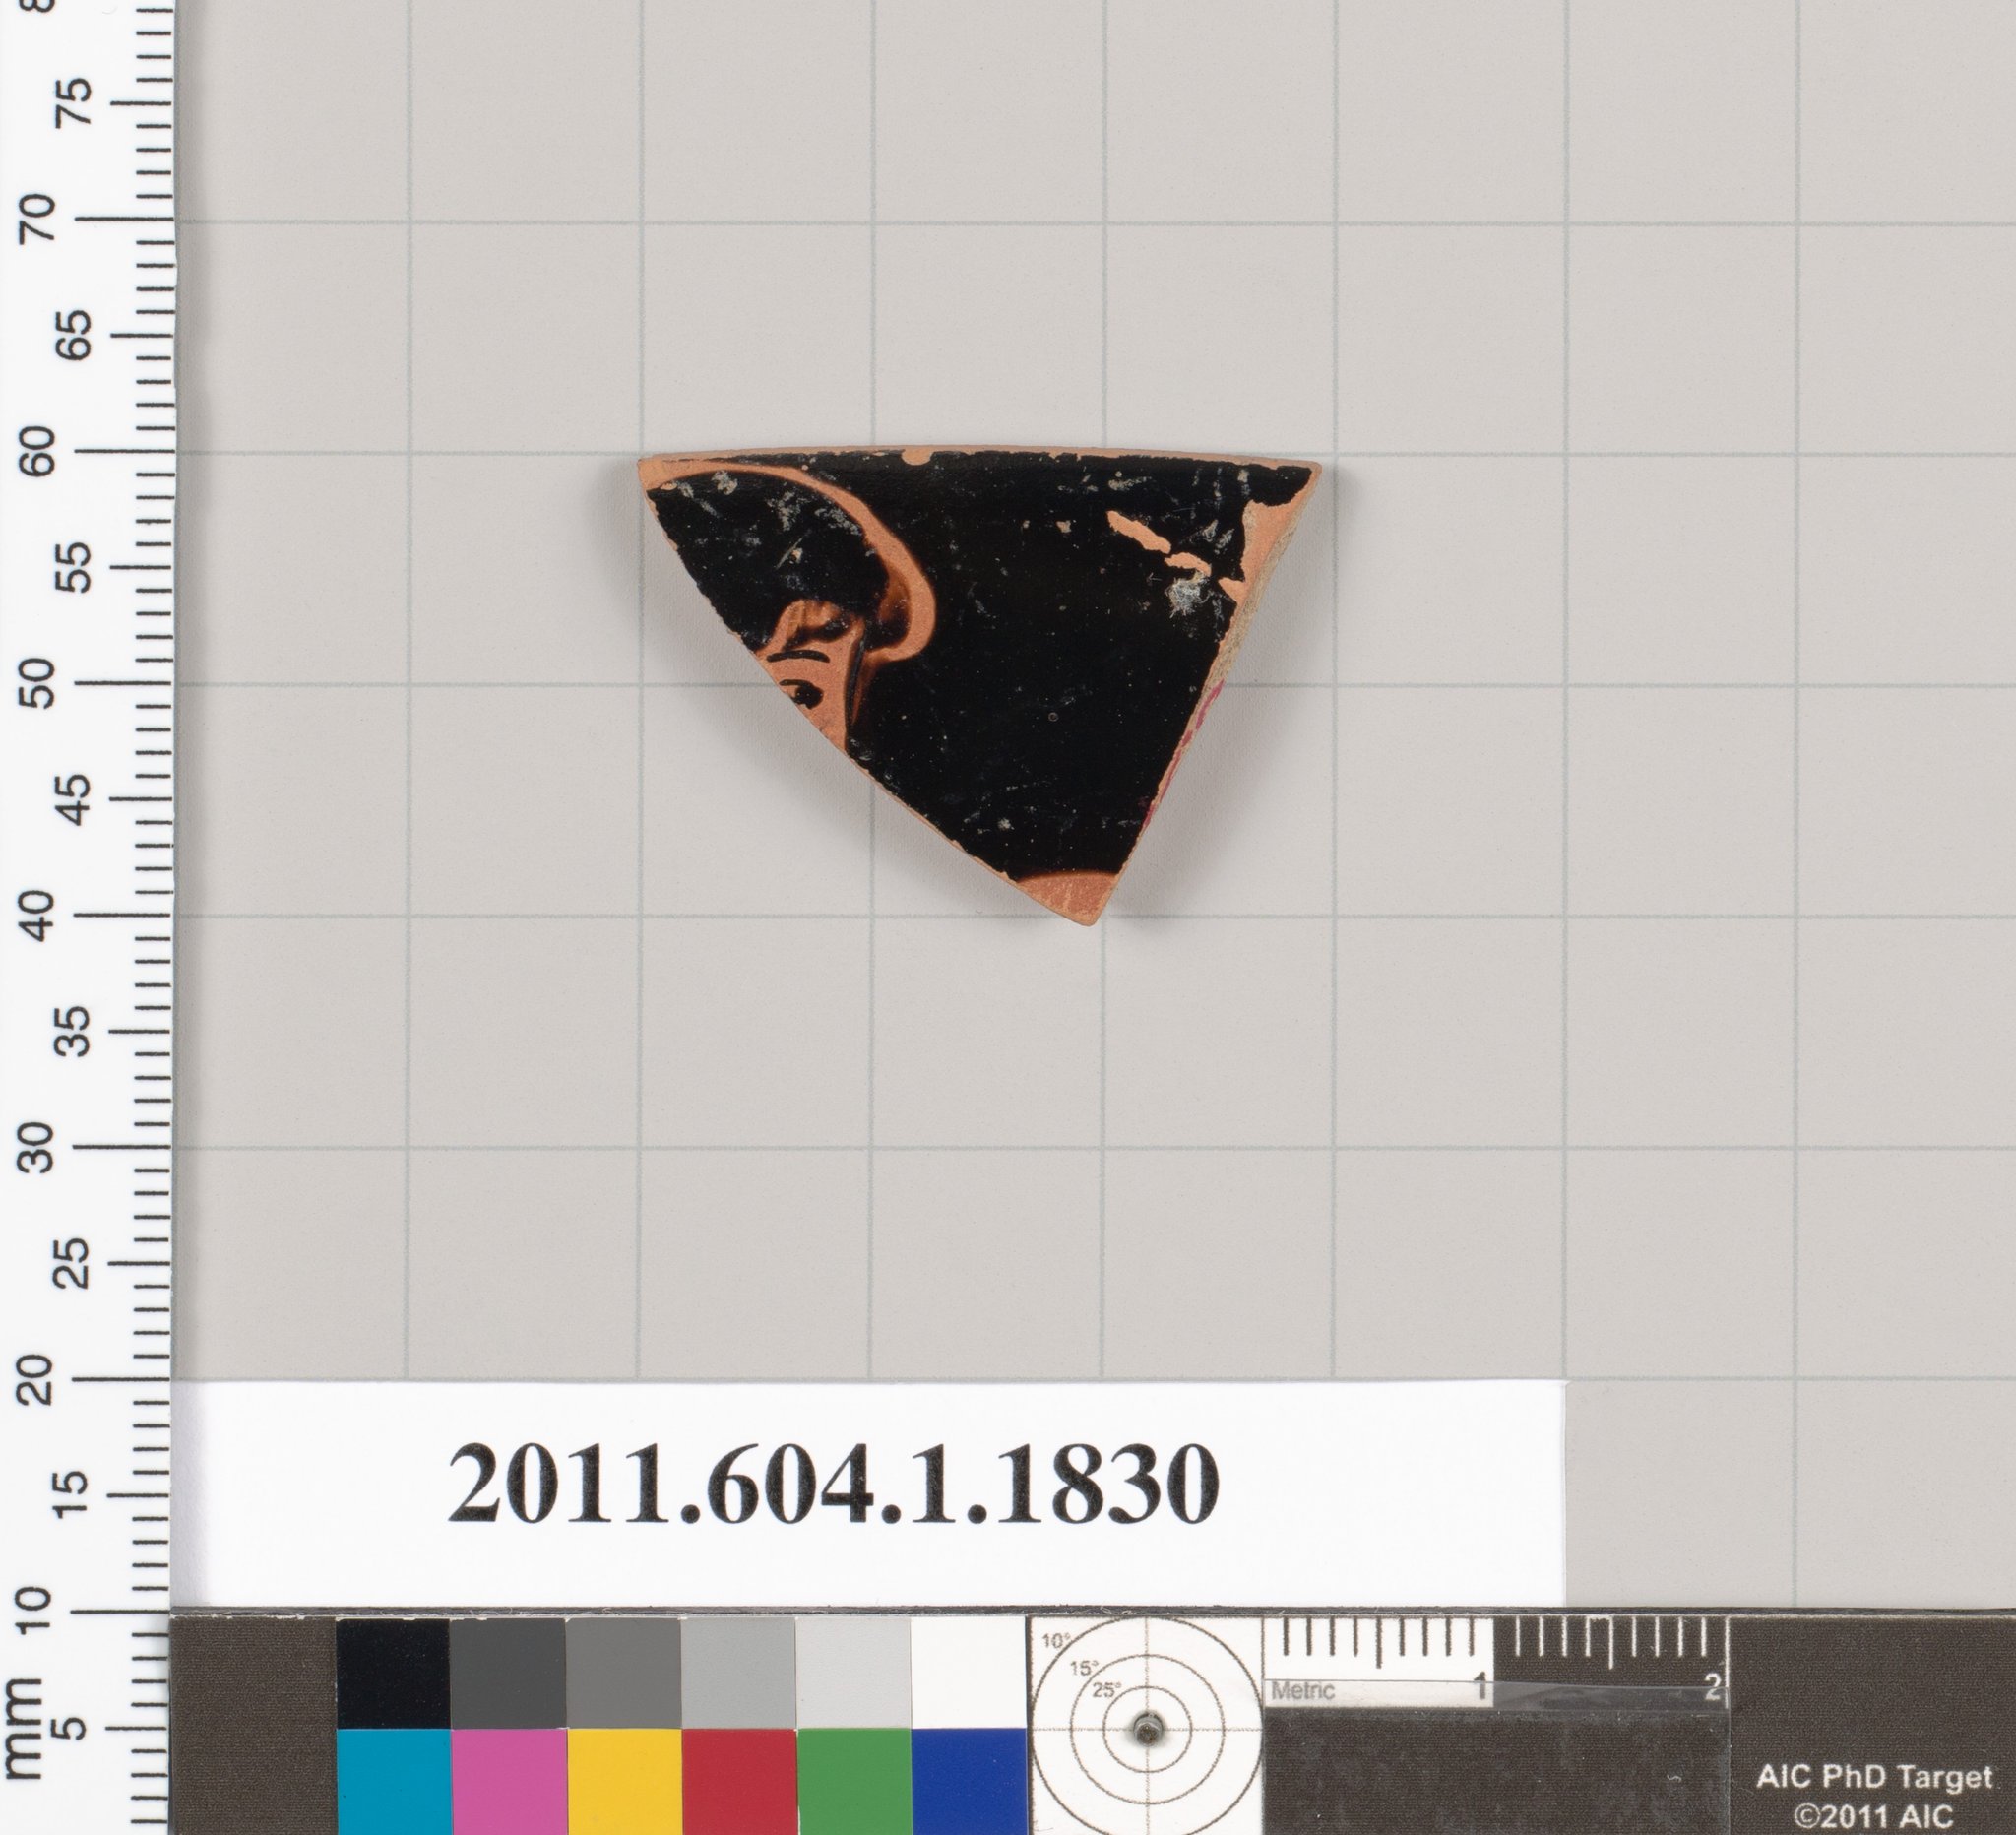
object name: kylix fragment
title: Terracotta rim fragment of a kylix (drinking cup)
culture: greek, attic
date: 480-470 BCE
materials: terracotta